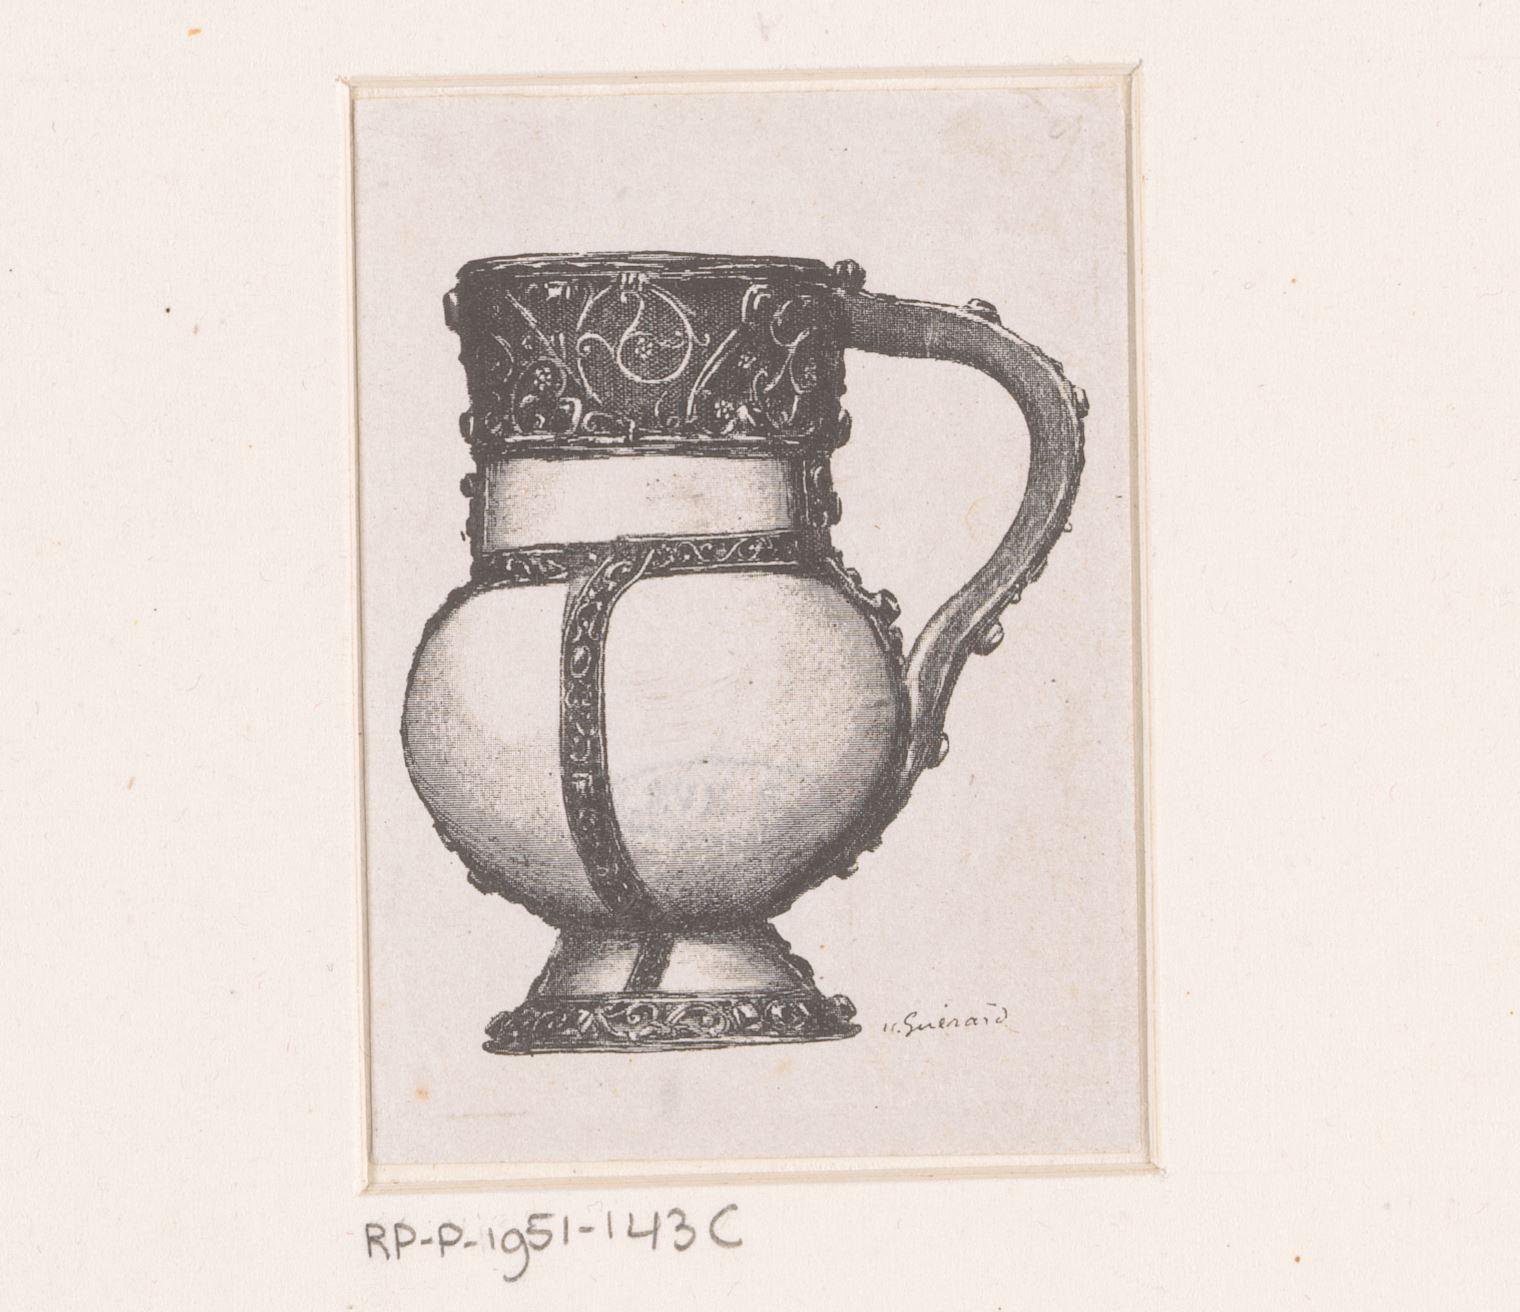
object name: print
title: Antieke kan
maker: henri charles guérard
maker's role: print maker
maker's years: 1846-1897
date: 1856-1897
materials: paper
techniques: engraving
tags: jar, jug (used as drinking-vessel)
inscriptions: collector's mark: Lugt 2228